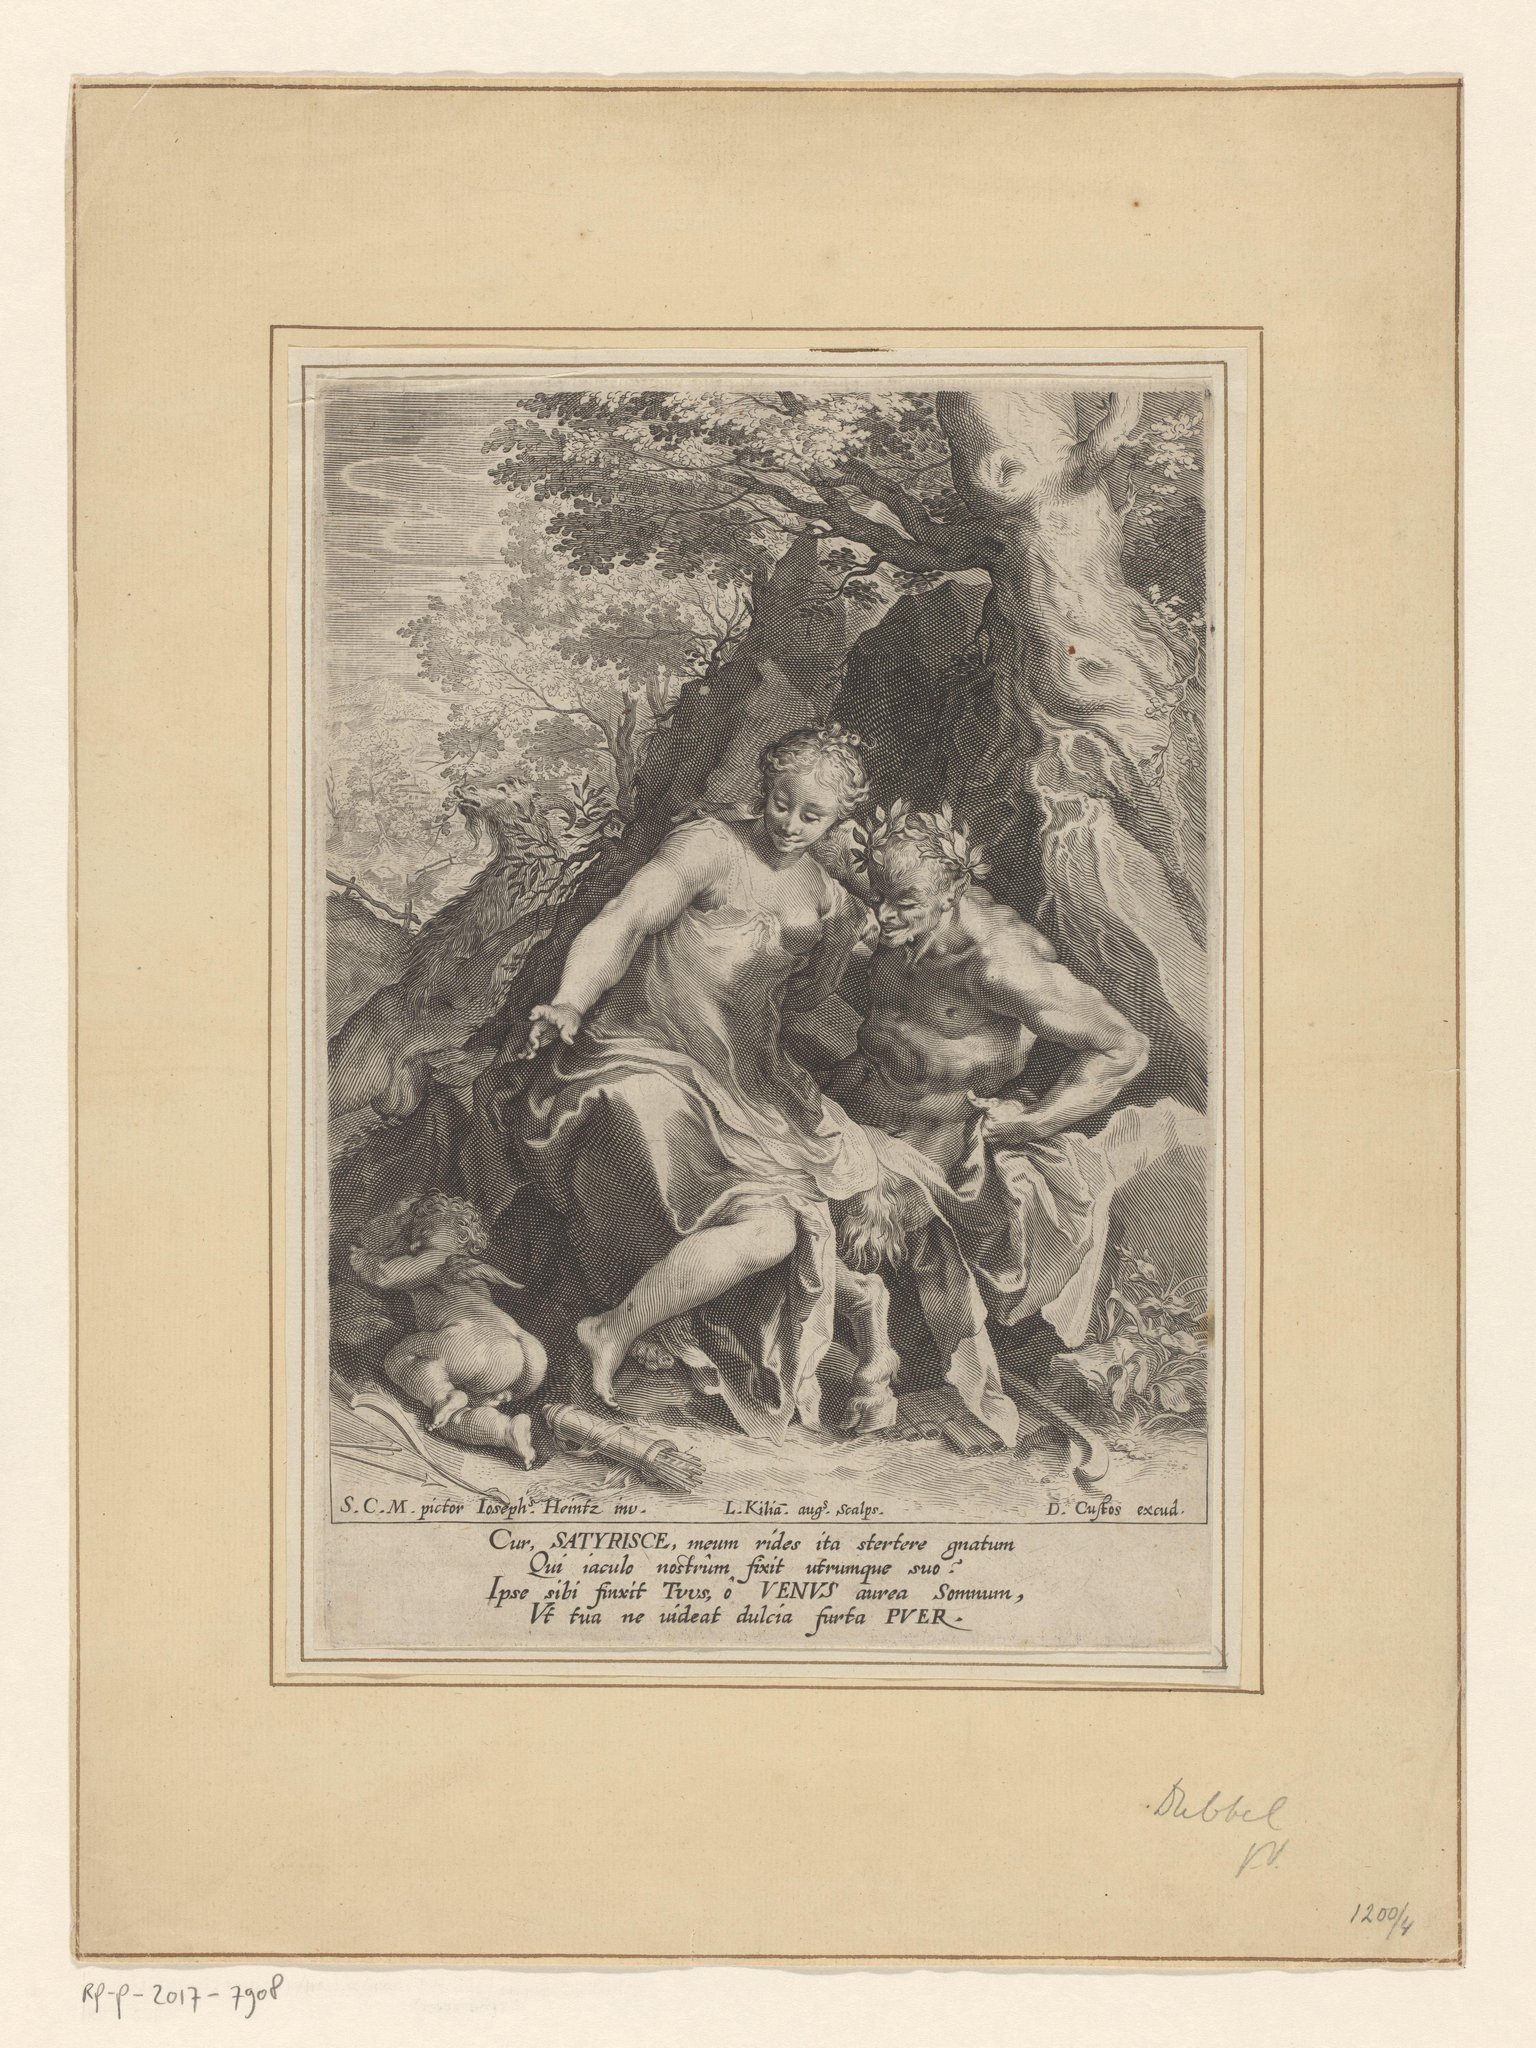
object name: print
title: Nimf op de knie van een sater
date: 1589-1615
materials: paper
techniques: engraving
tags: satyr(s) pursuing nymph(s)